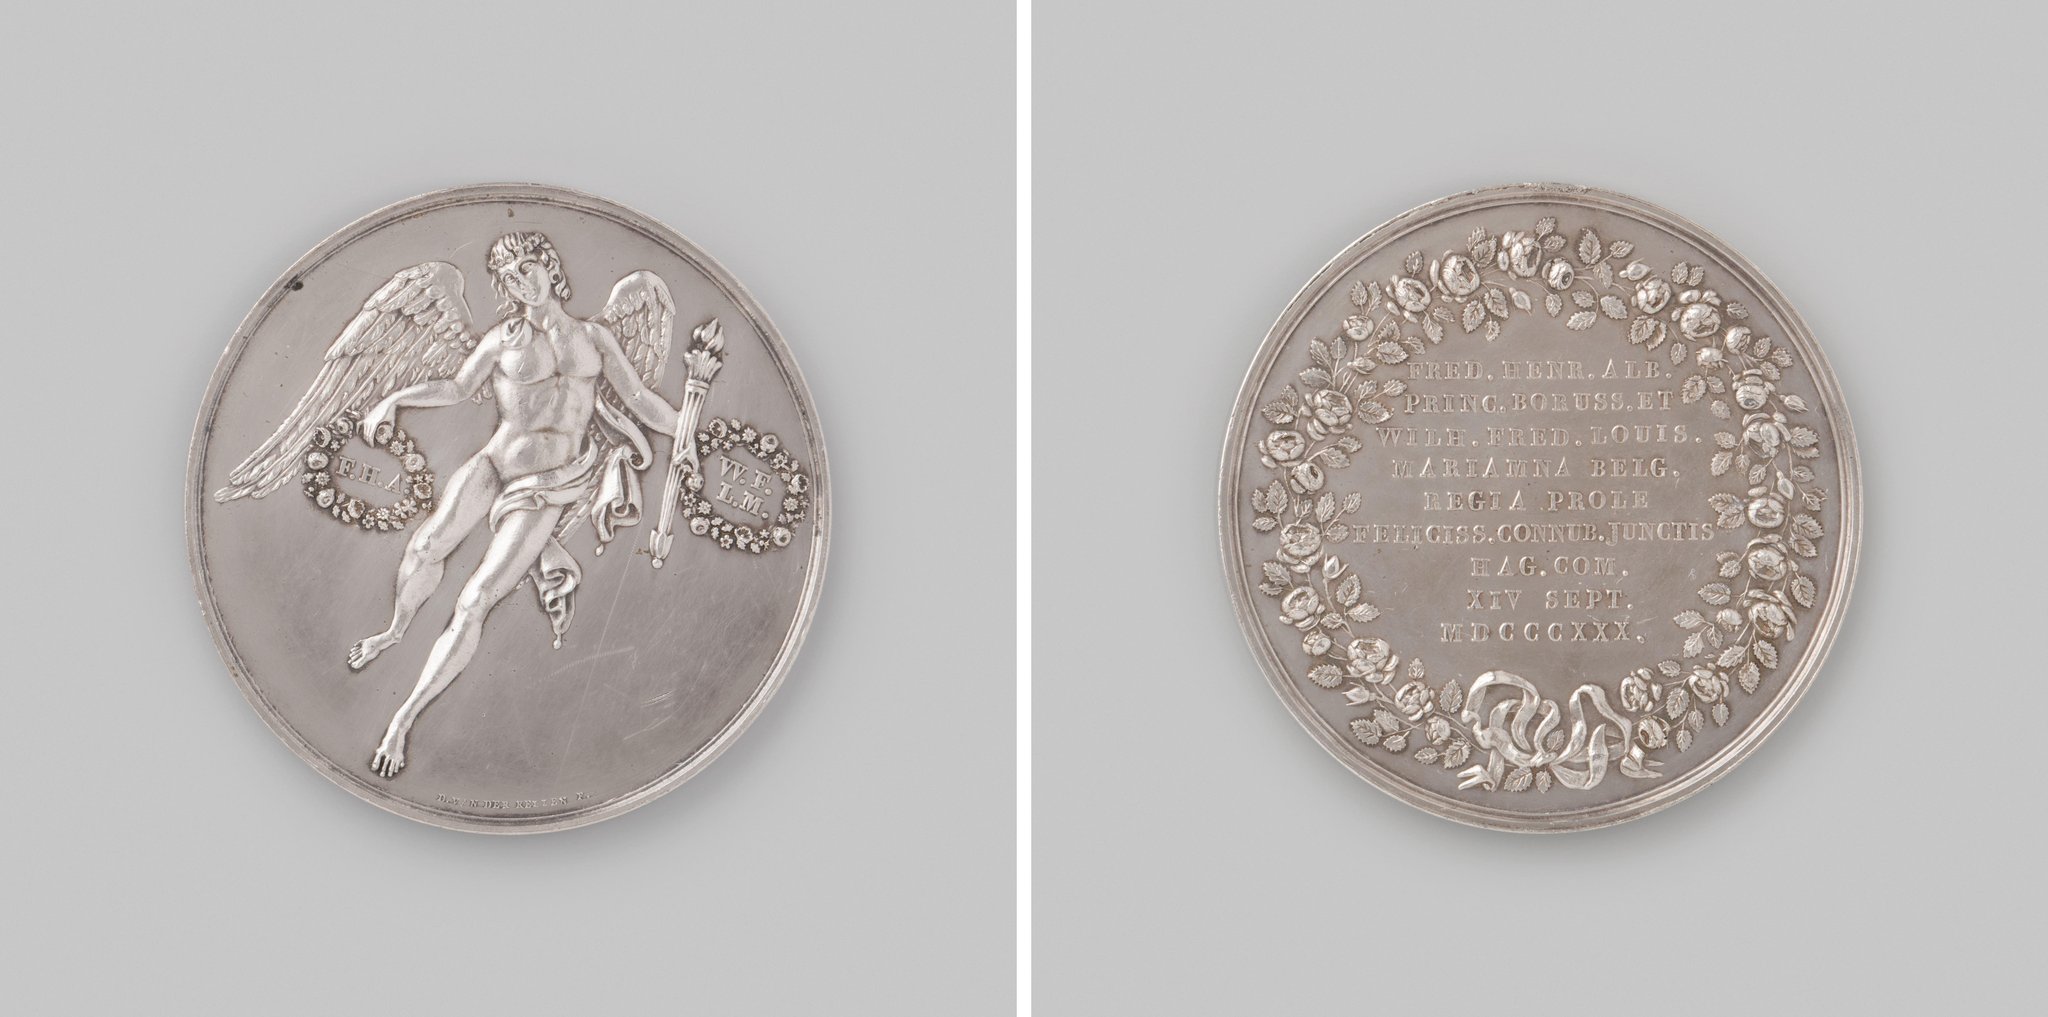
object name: history medal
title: Huwelijk van Albrecht Friedrich Heinrich, prins van Pruisen met Louisa Marianne, prinses der Nederlanden te 's-Gravenhage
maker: david van der kellen (1804-1879)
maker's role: die cutter, draughtsman, print maker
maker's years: 1804-1879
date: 1830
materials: silver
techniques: striking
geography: utrecht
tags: berlin, marianne (prinses der nederlanden), the hague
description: Zilveren penning. Voorzijde: gevleugelde Hymen met in rechterhand bloemenkrans met monogram erin en in linkerhand brandende huwelijkstoorts en bloemenkrans met monogram erin. Keerzijde: opschrift binnen rozekrans.